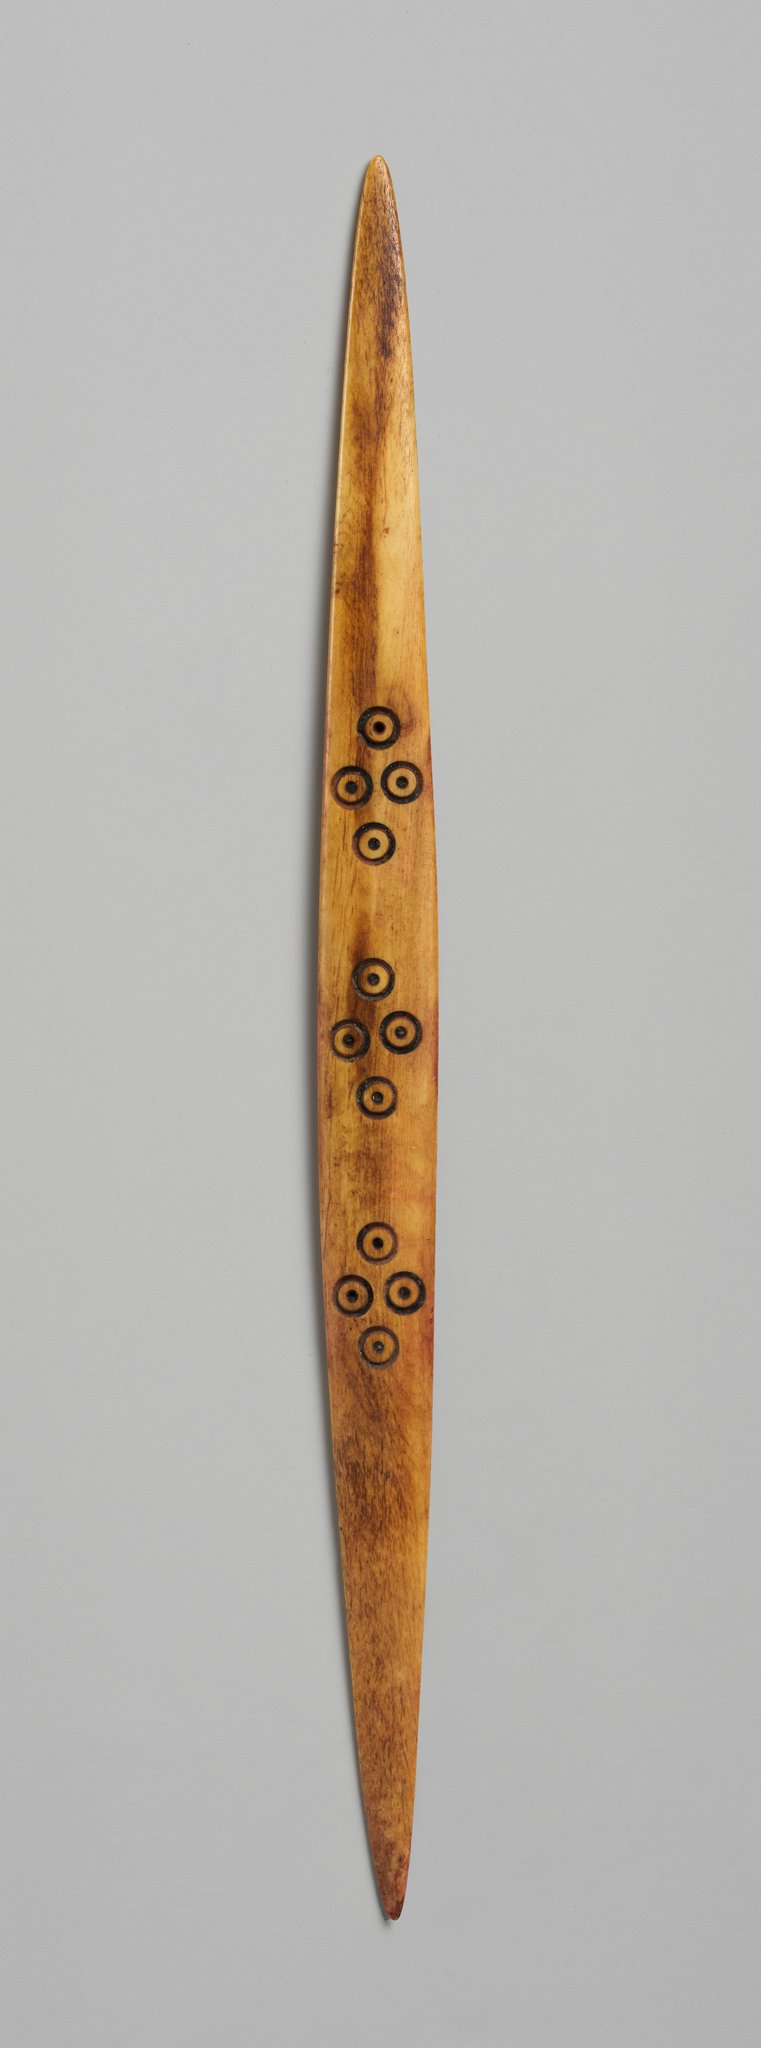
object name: weaving tool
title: Weaving Sword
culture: peruvian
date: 901-1600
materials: bone, pigment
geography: peru